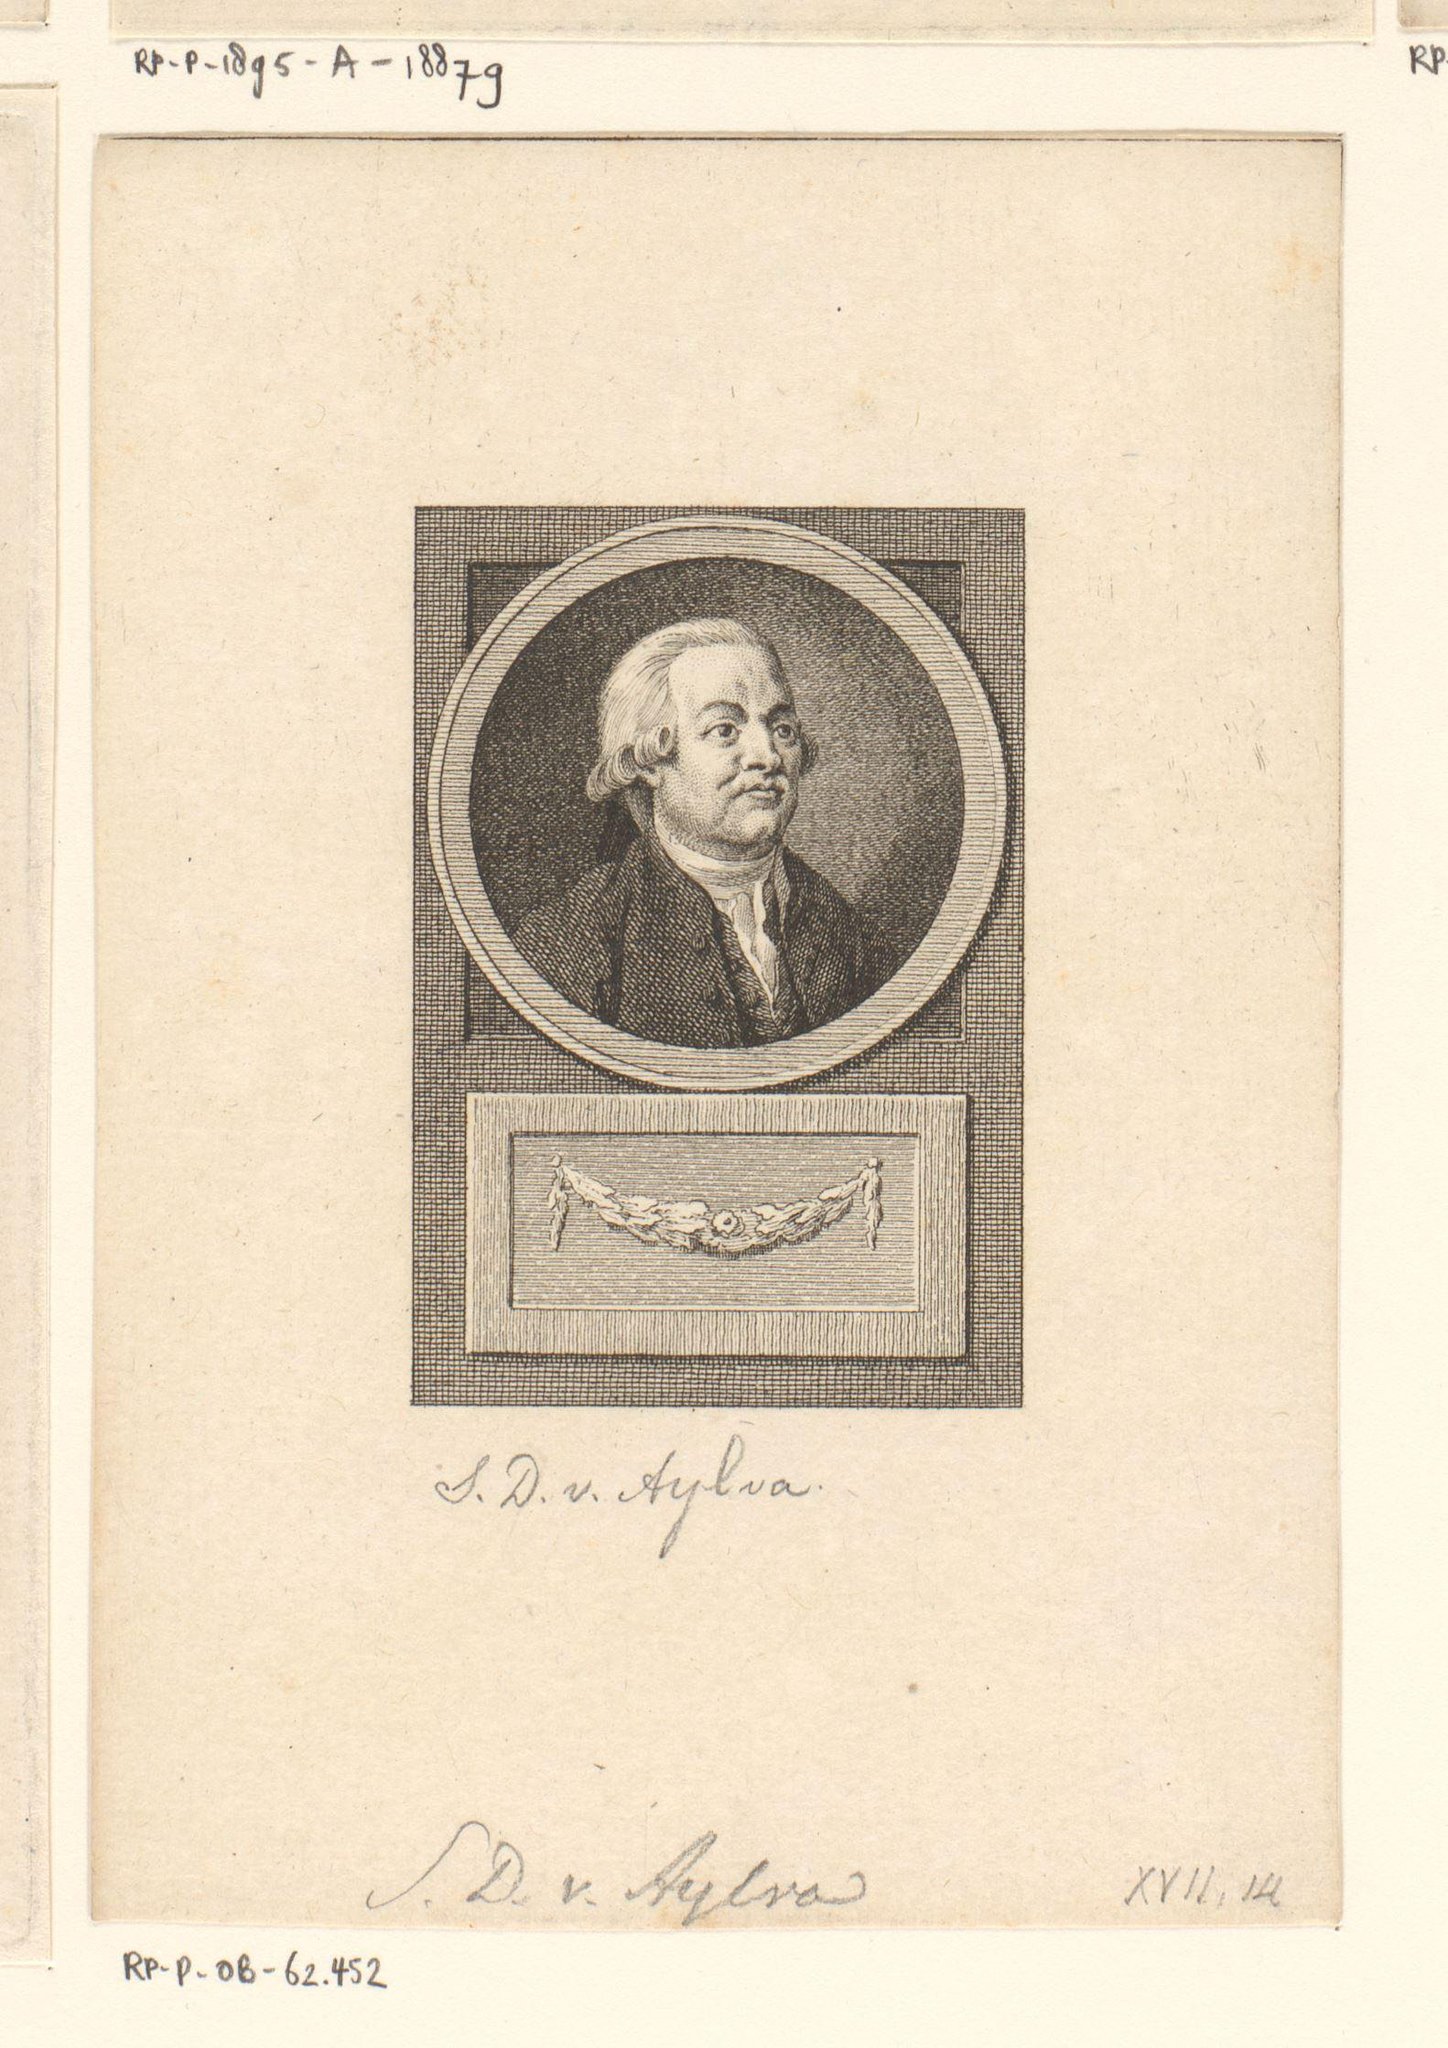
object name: print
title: Portret van de grietman Sicco Douwes van Aylva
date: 1783-1795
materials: paper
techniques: etching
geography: amsterdam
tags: holwerd, grietman, sicco douwe van aylva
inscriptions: collector's mark: Lugt 2228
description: Latere staat prent gebruikt in: Fokke, Jan. Geschiedenissen der Vereenigde Nederlanden voor de vaderlandsche jeugd Ie-XXVste deel. Amsterdam: Johannes Allart, 1783-1795. Deel XVII.